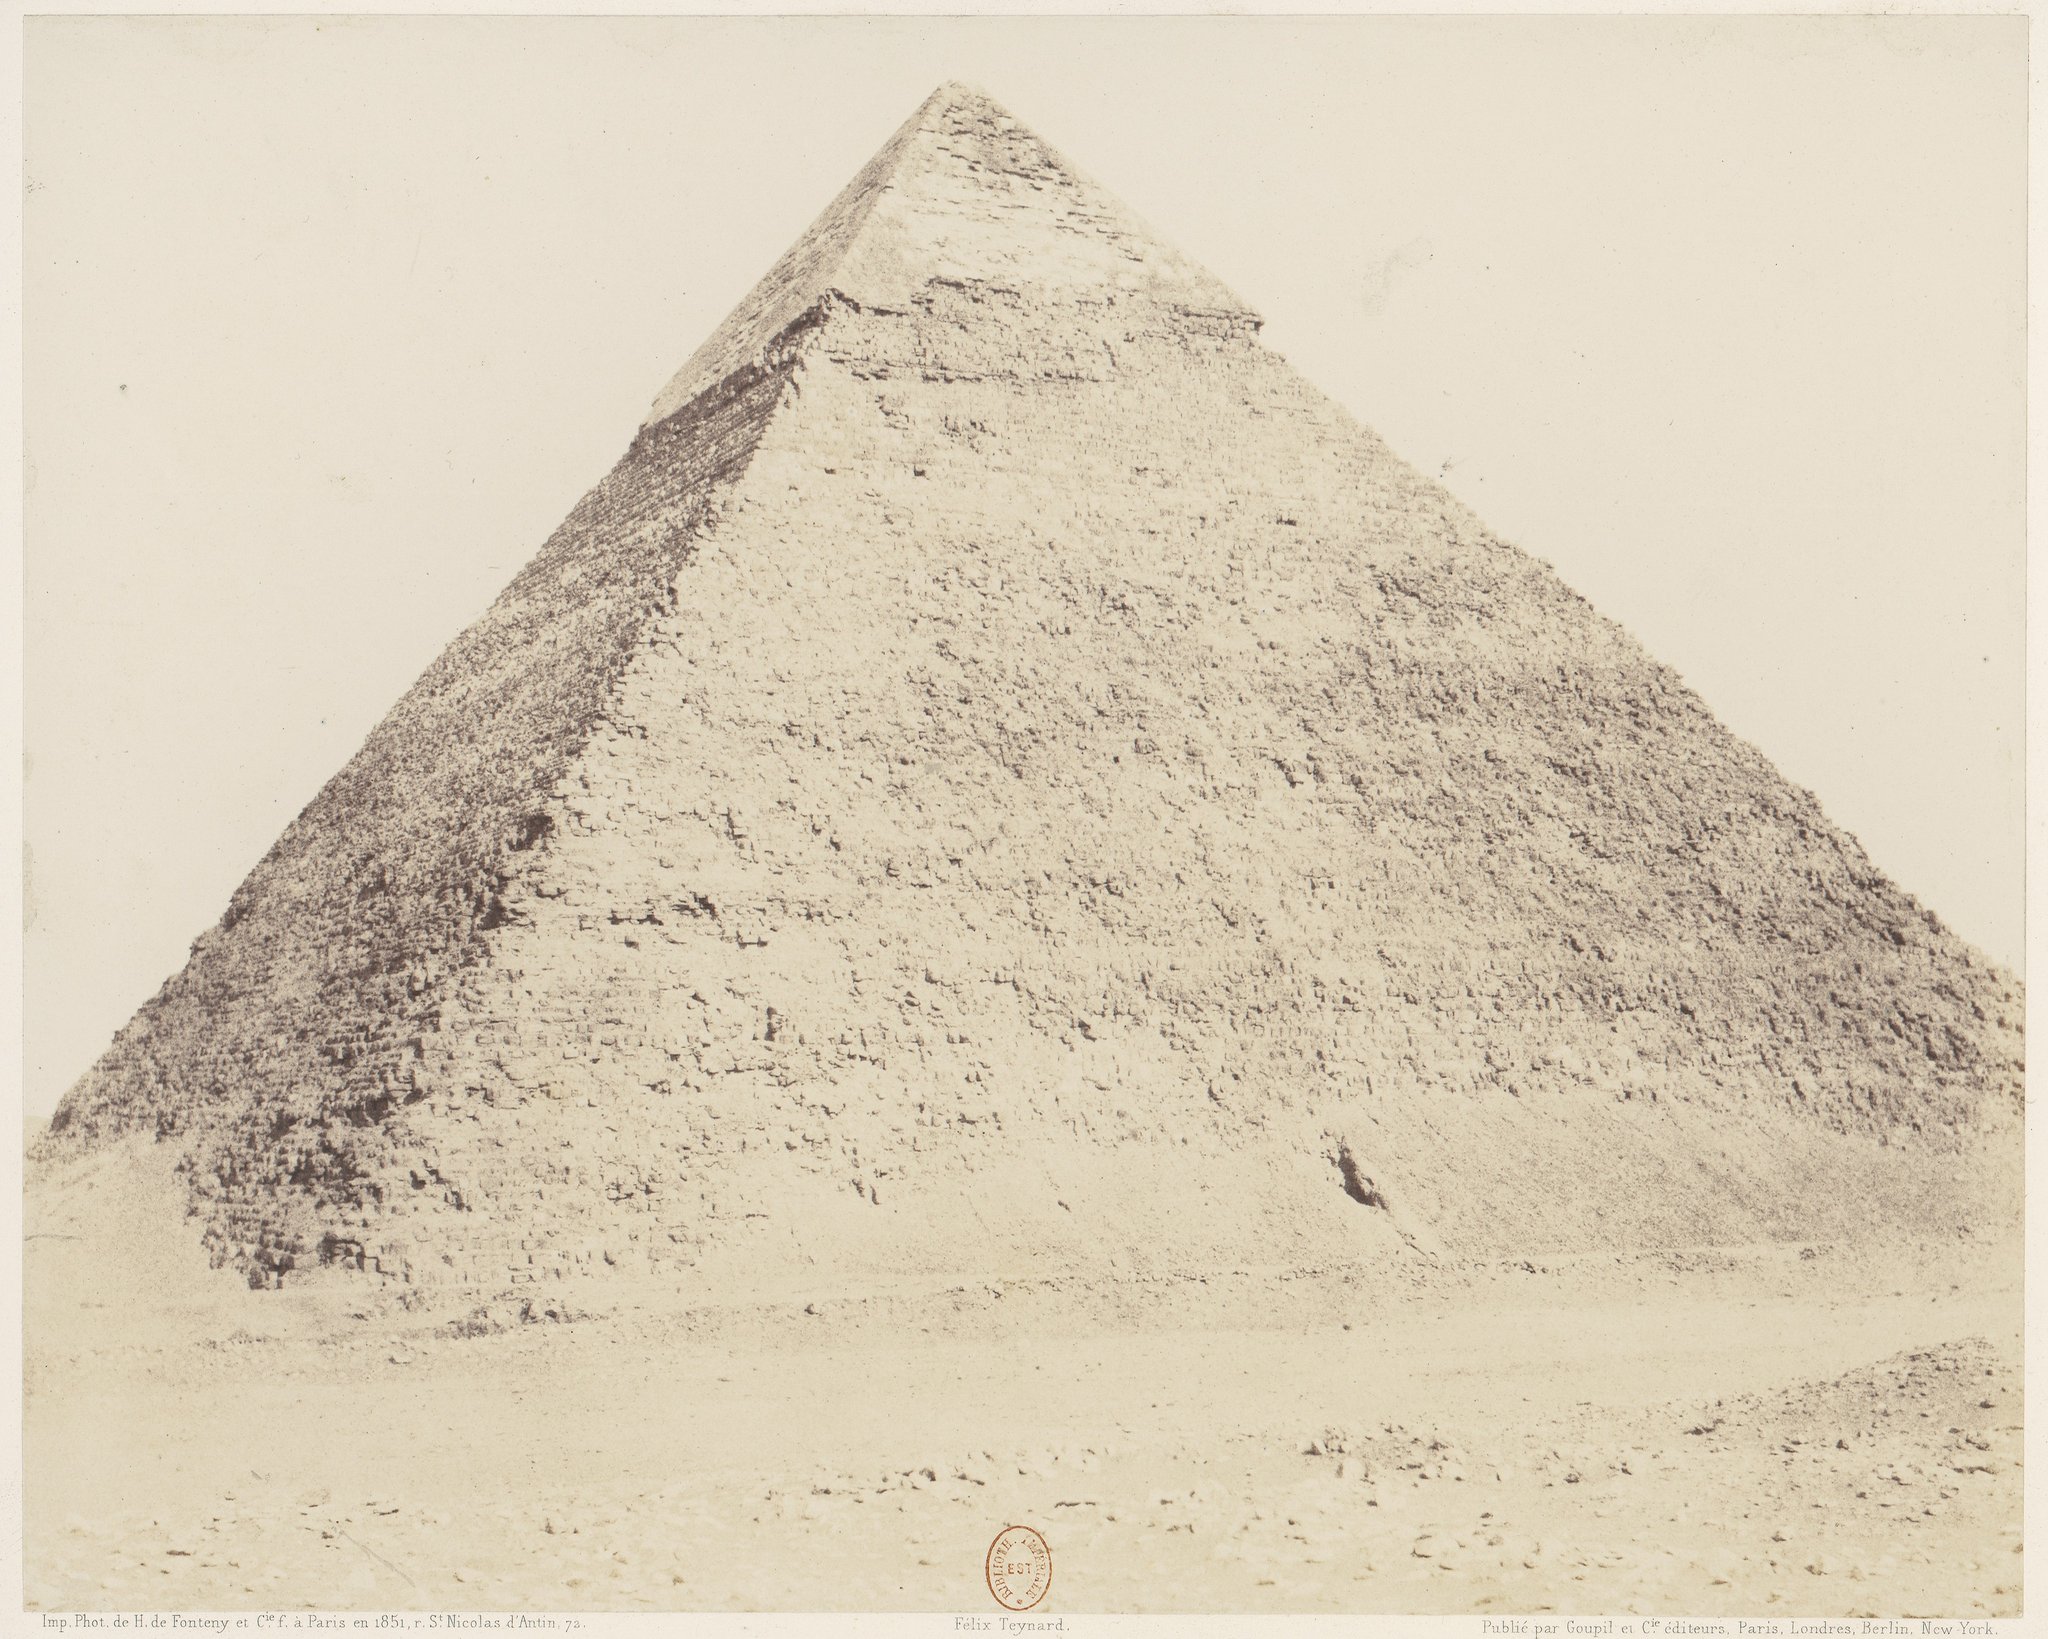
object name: photograph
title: Djîzeh (Nécropole de Memphis), Pyramide de Chéphren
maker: félix teynard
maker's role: artist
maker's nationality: french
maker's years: 1817-1892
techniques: paper negative, salted paper print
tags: architecture,pyramids